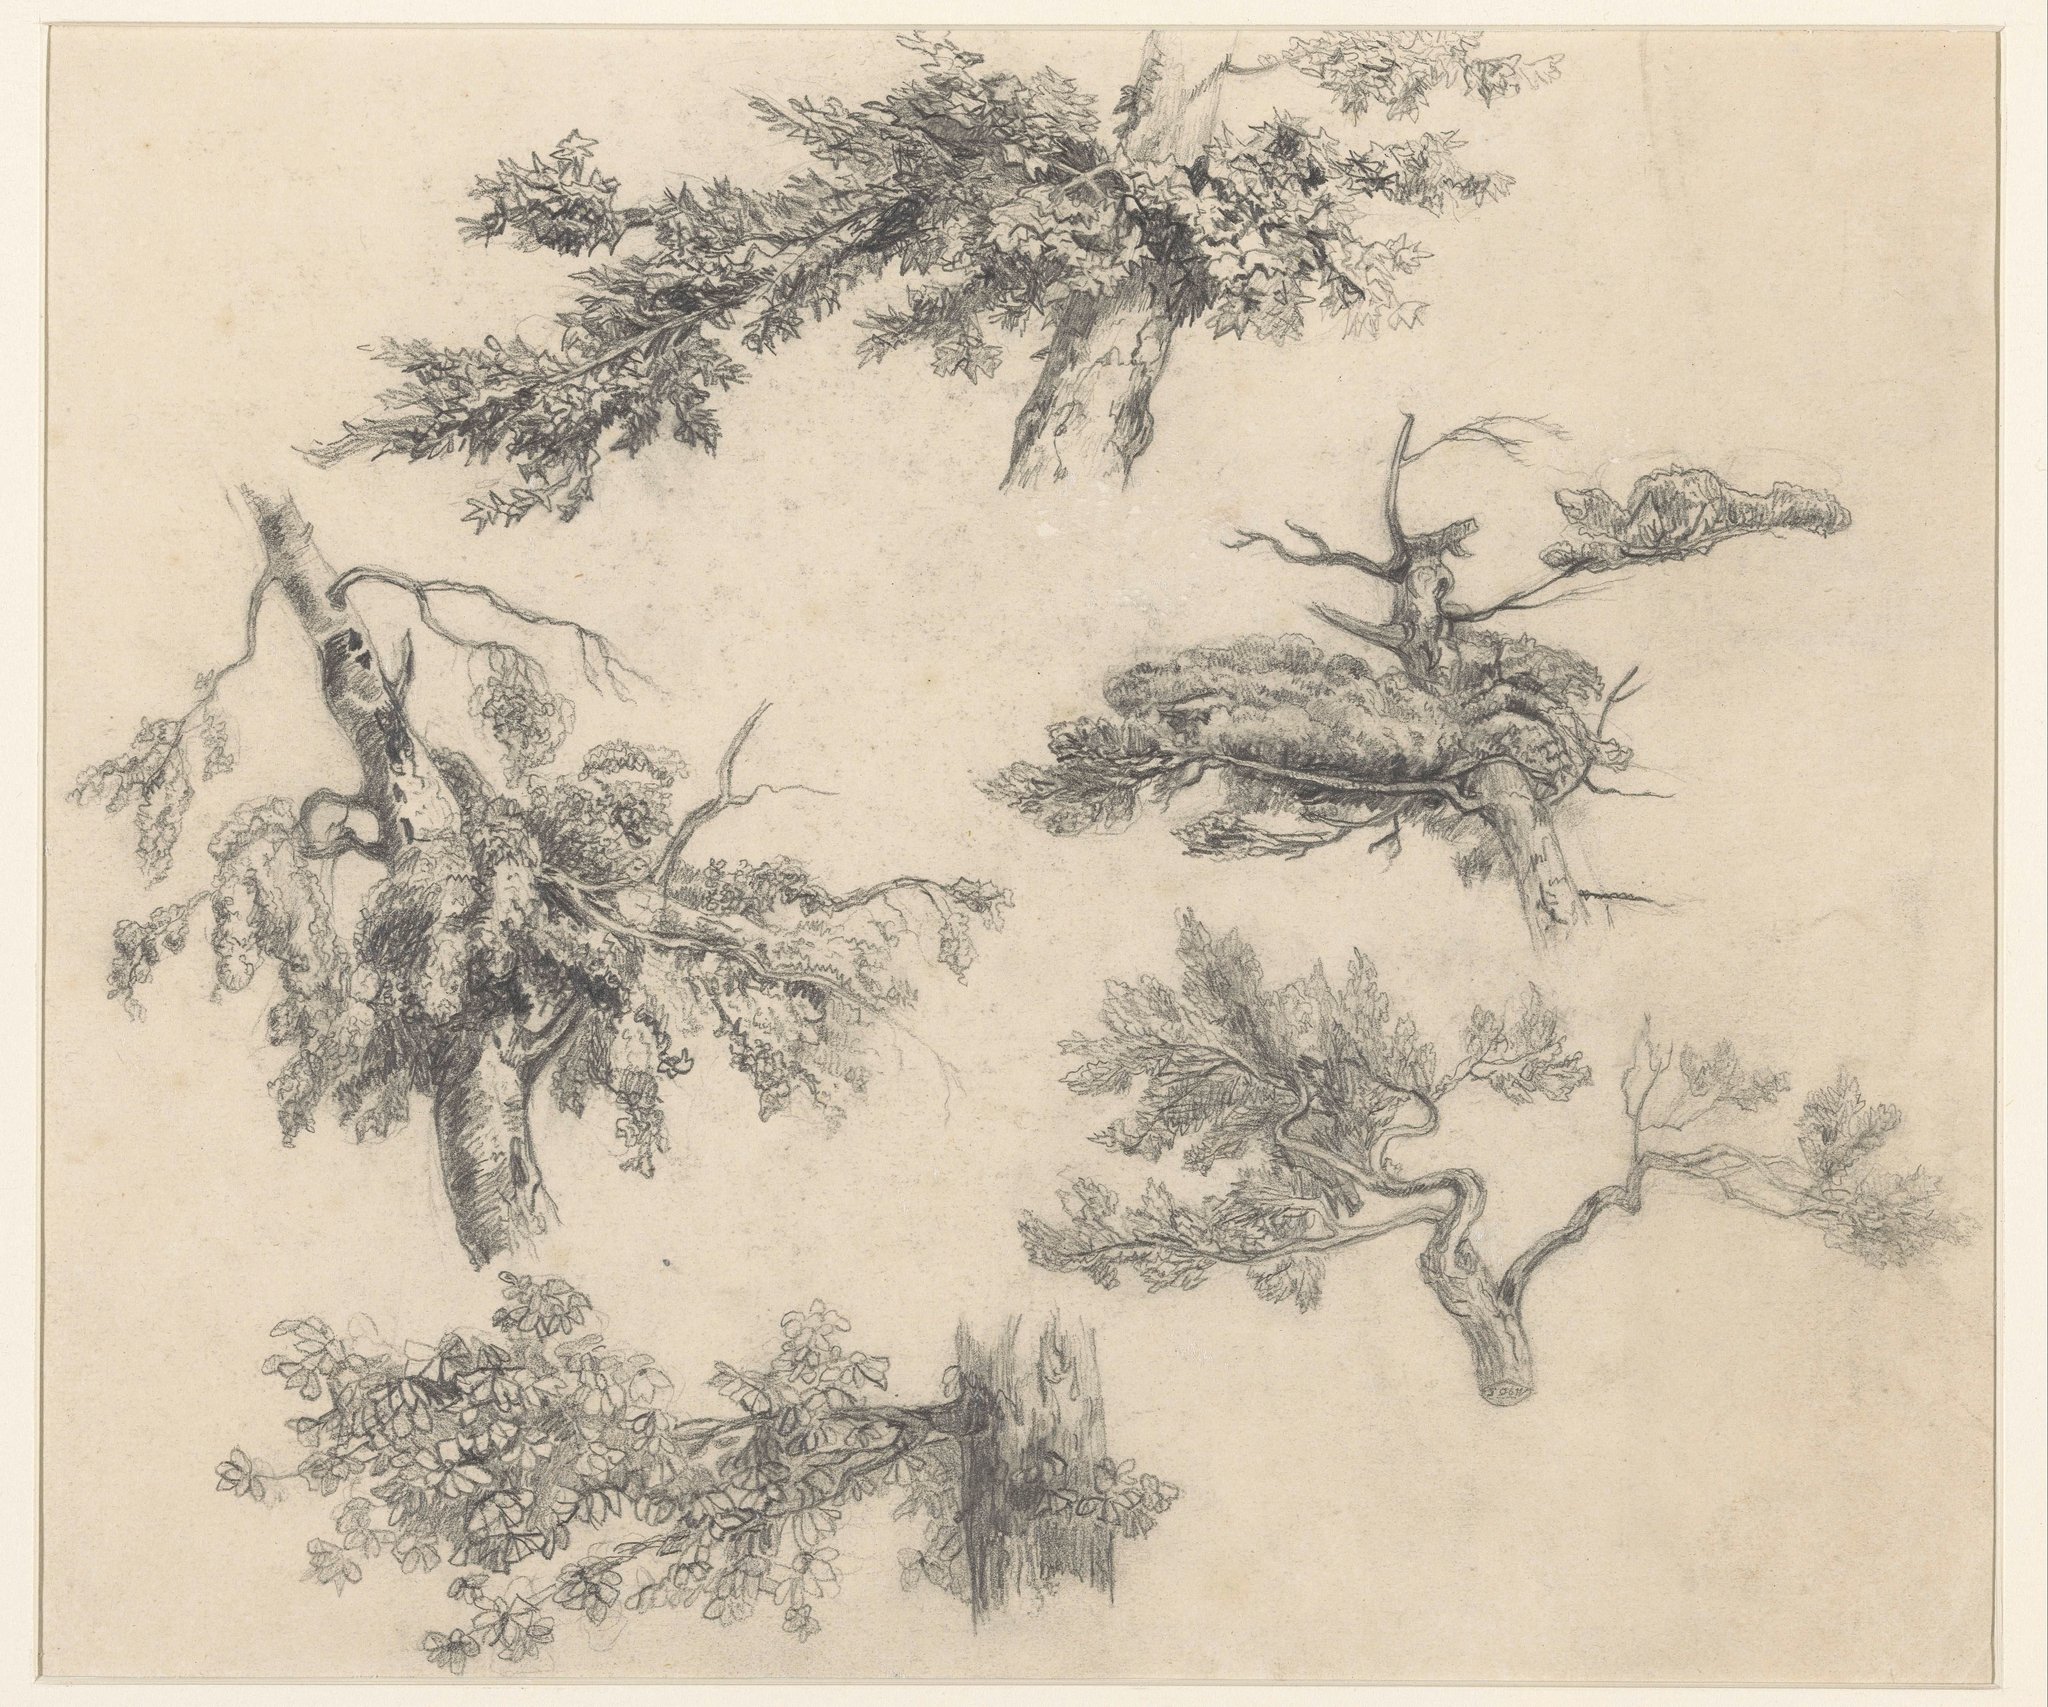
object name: drawing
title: Boomstudies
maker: frederik hendrik weissenbruch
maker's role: draughtsman, print maker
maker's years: 1828-1887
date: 1838-1887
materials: paper, pencil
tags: trees